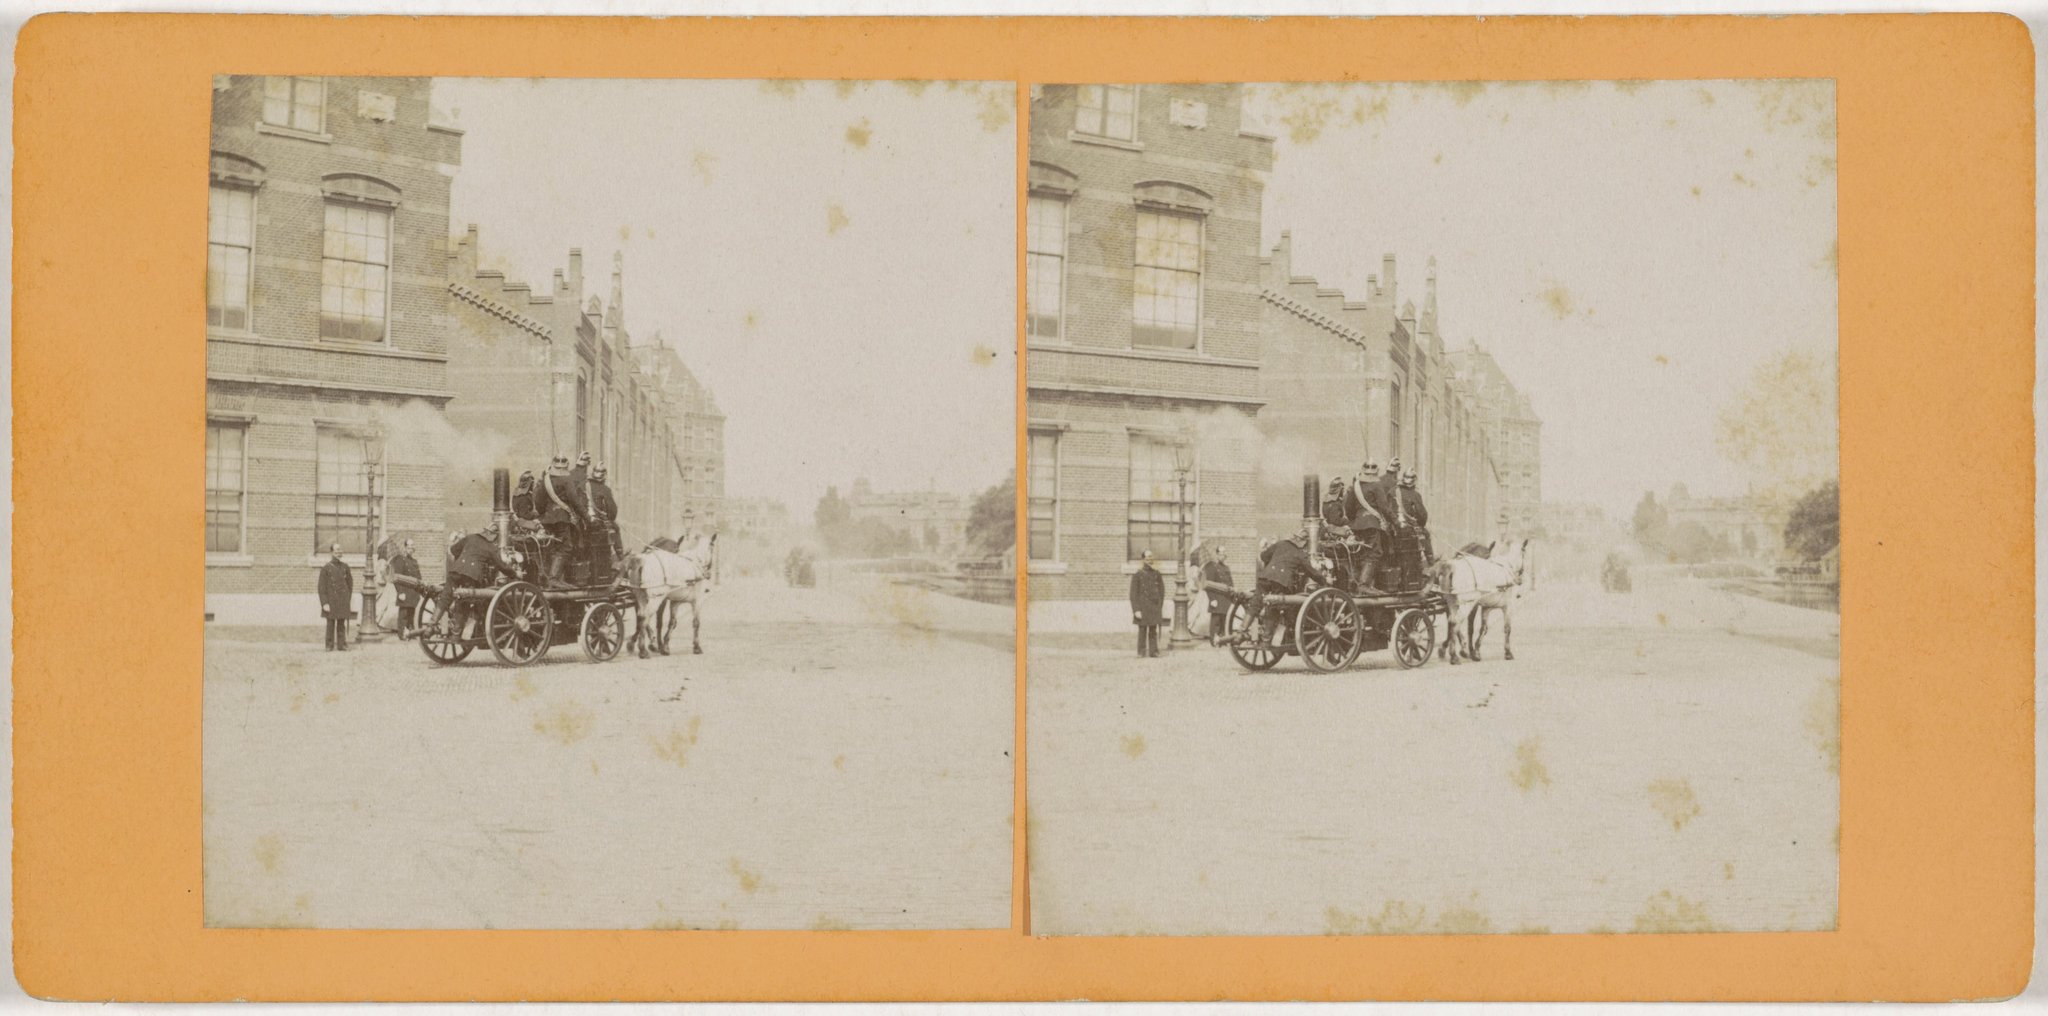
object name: stereograph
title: Brandweerwagen en een stoomspuit aan de Hobbemakade in Amsterdam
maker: Anonymous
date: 1873-1890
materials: cardboard, paper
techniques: albumen print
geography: amsterdam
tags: urban housing, fire-department, fire-brigade, street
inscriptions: retailer's mark: ‘*GEBR. DOUWES*/ ATELIERS/ Warmoesstraat 73./ AMSTERDAM.’, inscription: ‘146’